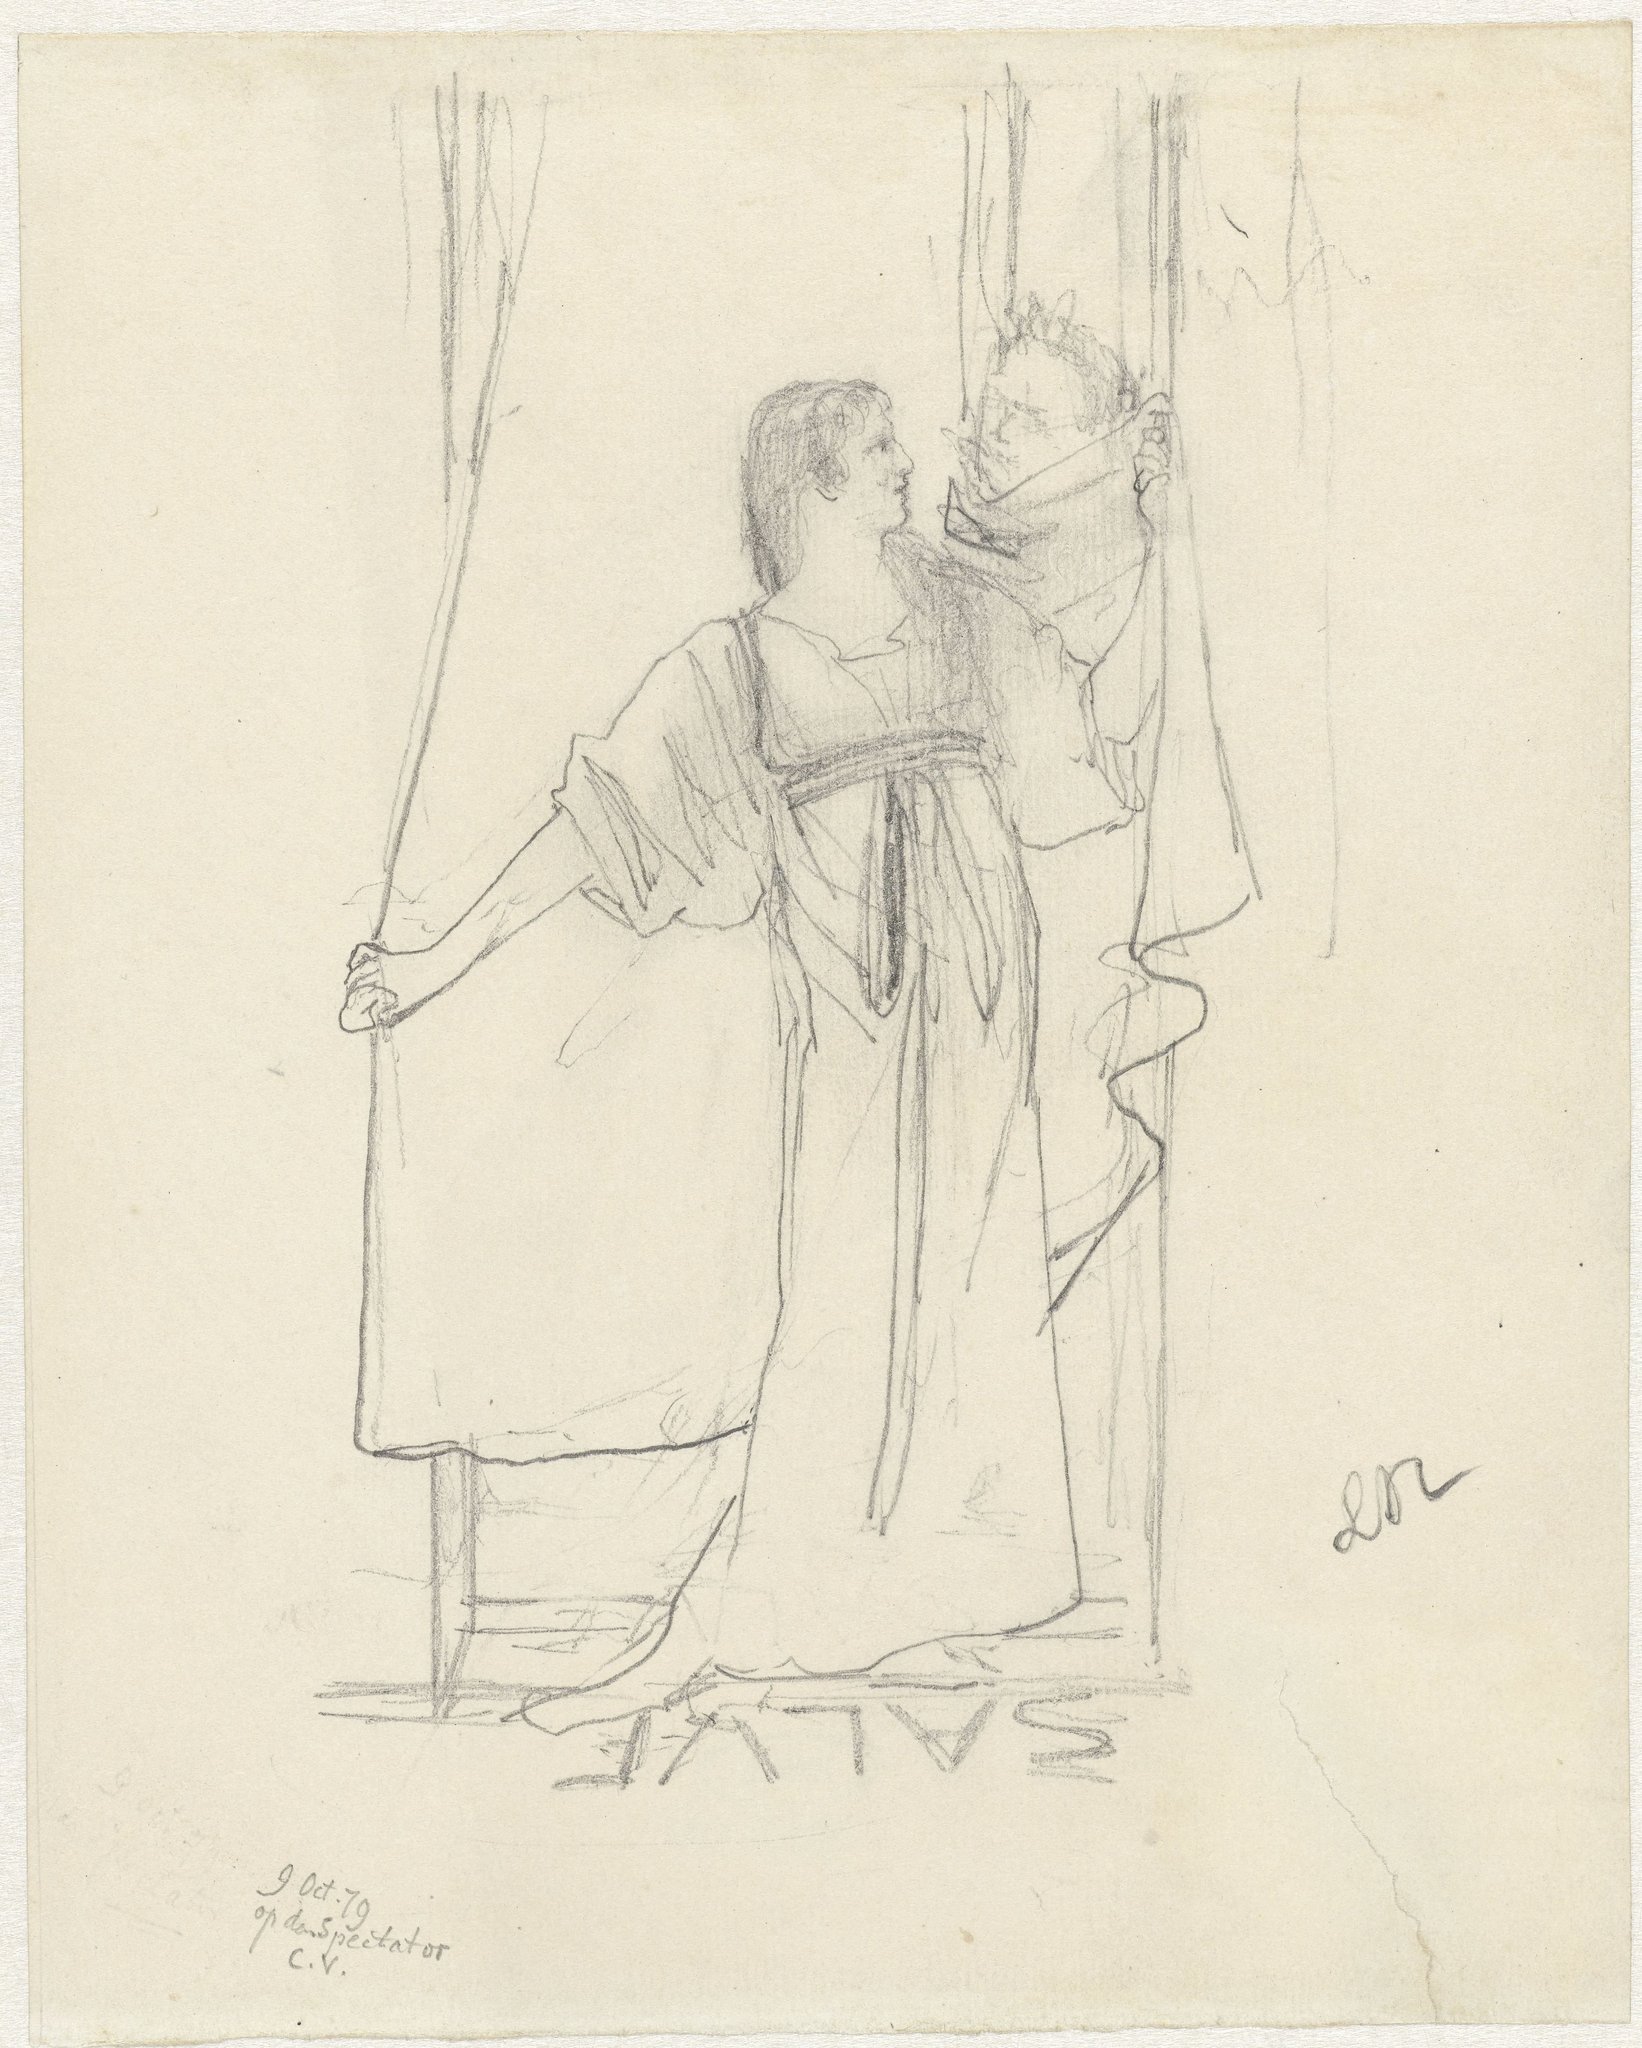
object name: drawing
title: Staande vrouw sprekend met man achter gordijn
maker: lourens alma tadema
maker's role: draughtsman, print maker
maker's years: 1836-1912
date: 1879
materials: paper, pencil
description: Ontwerptekening voor prent in 'De Spectator'.